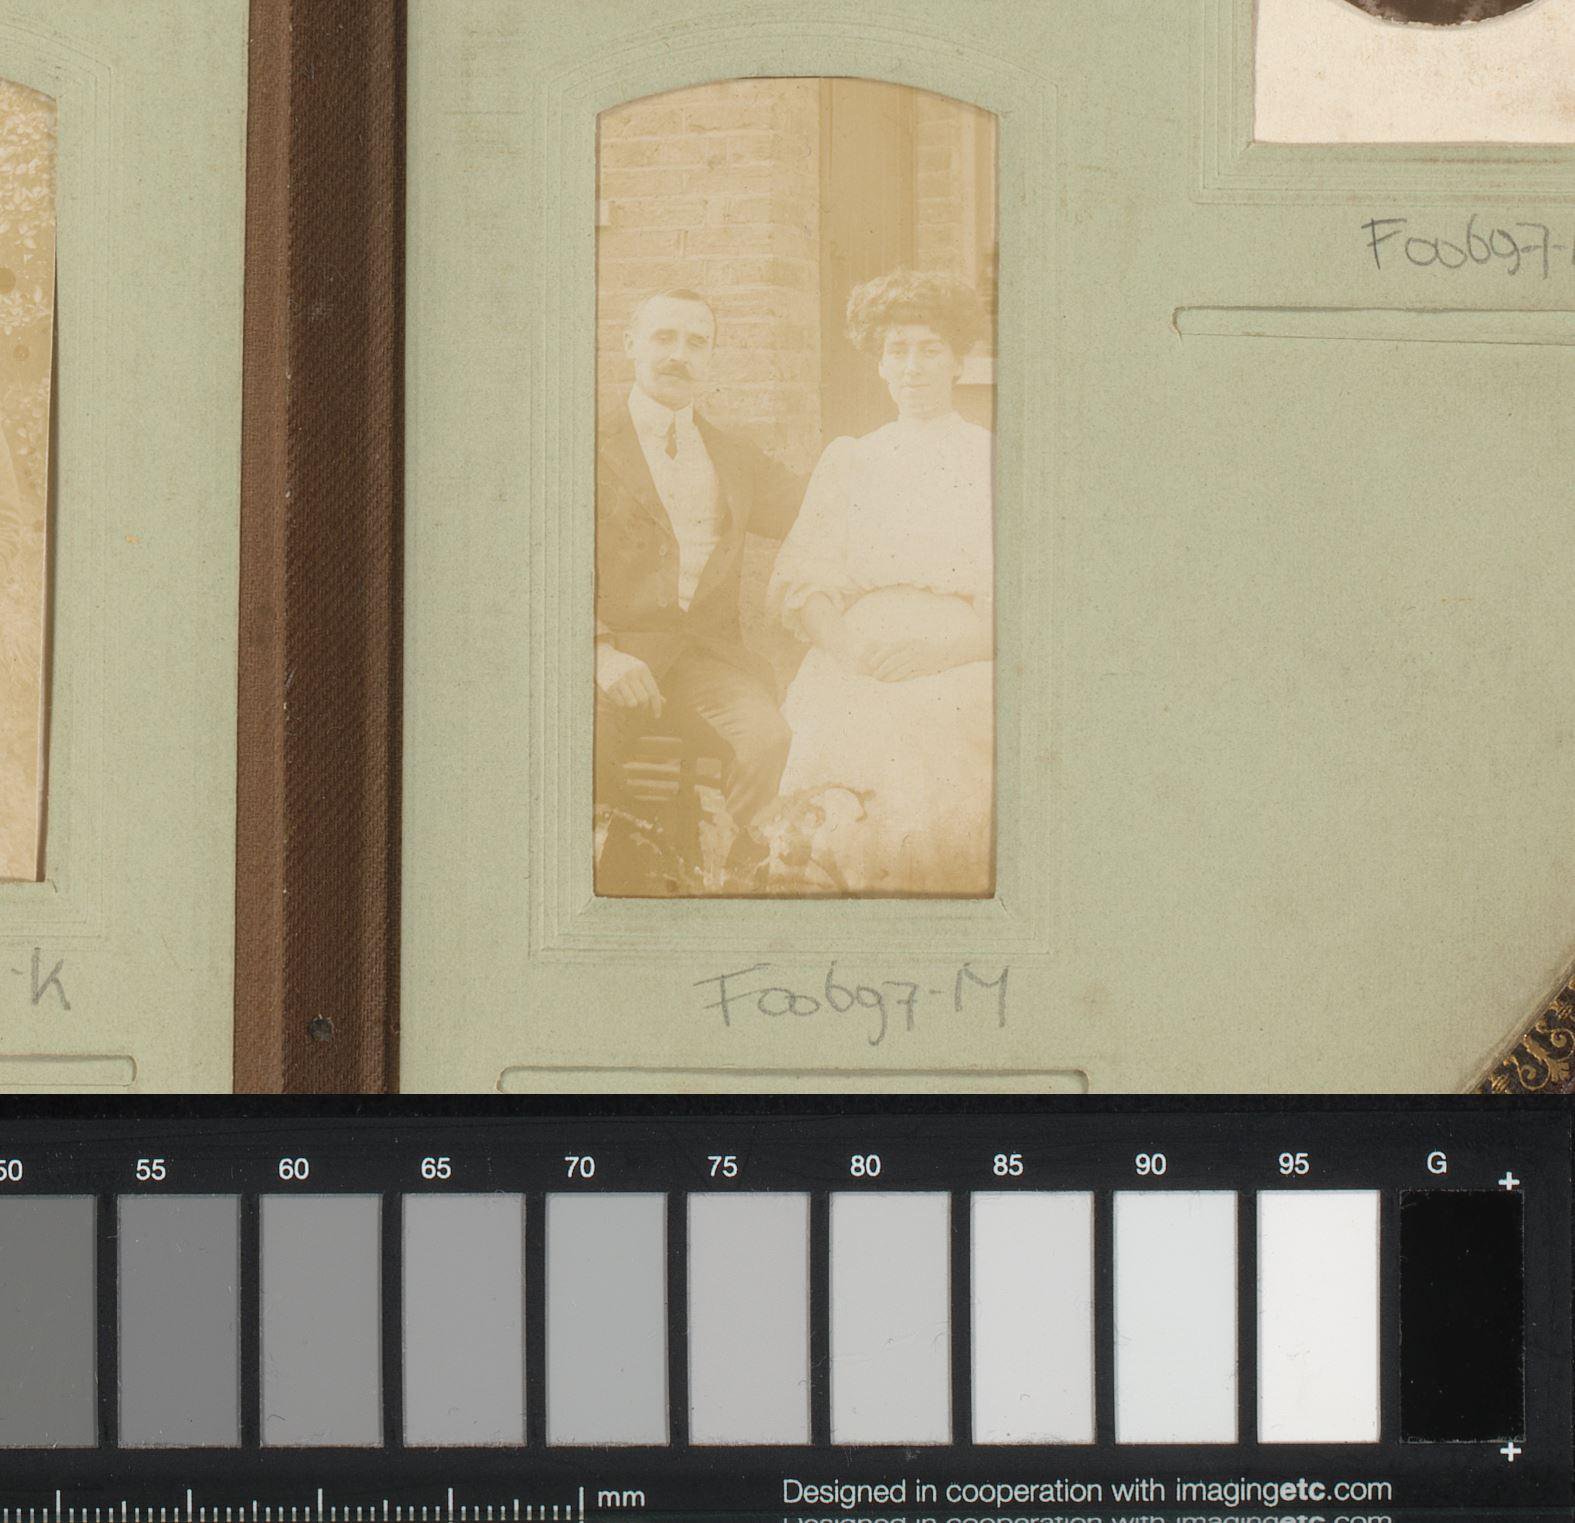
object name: photograph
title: Portret van een man en vrouw voor een huis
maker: Anonymous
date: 1890-1915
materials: photographic support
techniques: gelatin silver print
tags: adult woman, adult man, historical persons